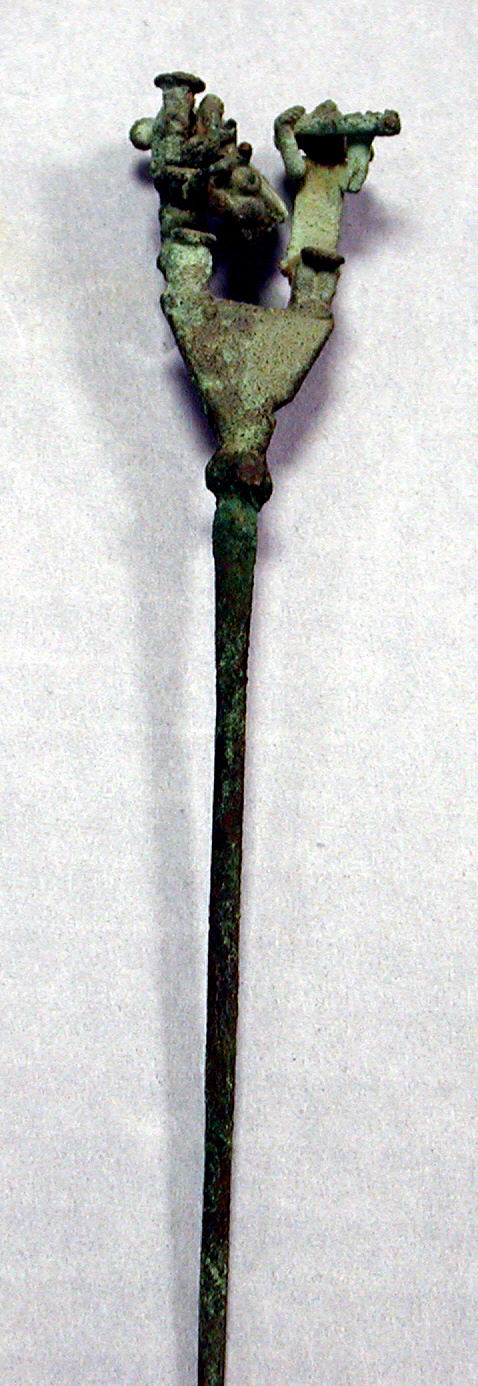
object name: pin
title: Copper Pin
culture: chimú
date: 1101-1500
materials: copper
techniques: casting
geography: peru